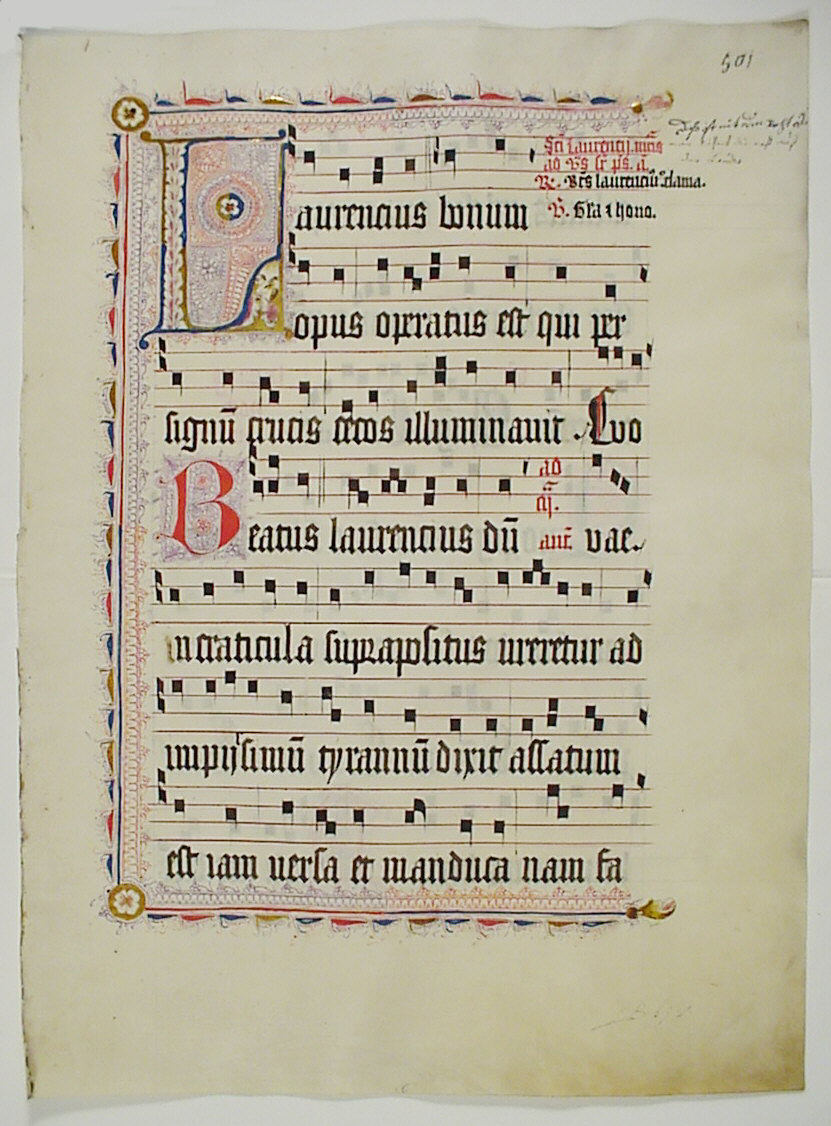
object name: antiphonary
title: Manuscript Leaf with Initial L, from an Antiphonary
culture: german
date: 1426-1450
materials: ink, metal leaf, parchment, paint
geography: germany